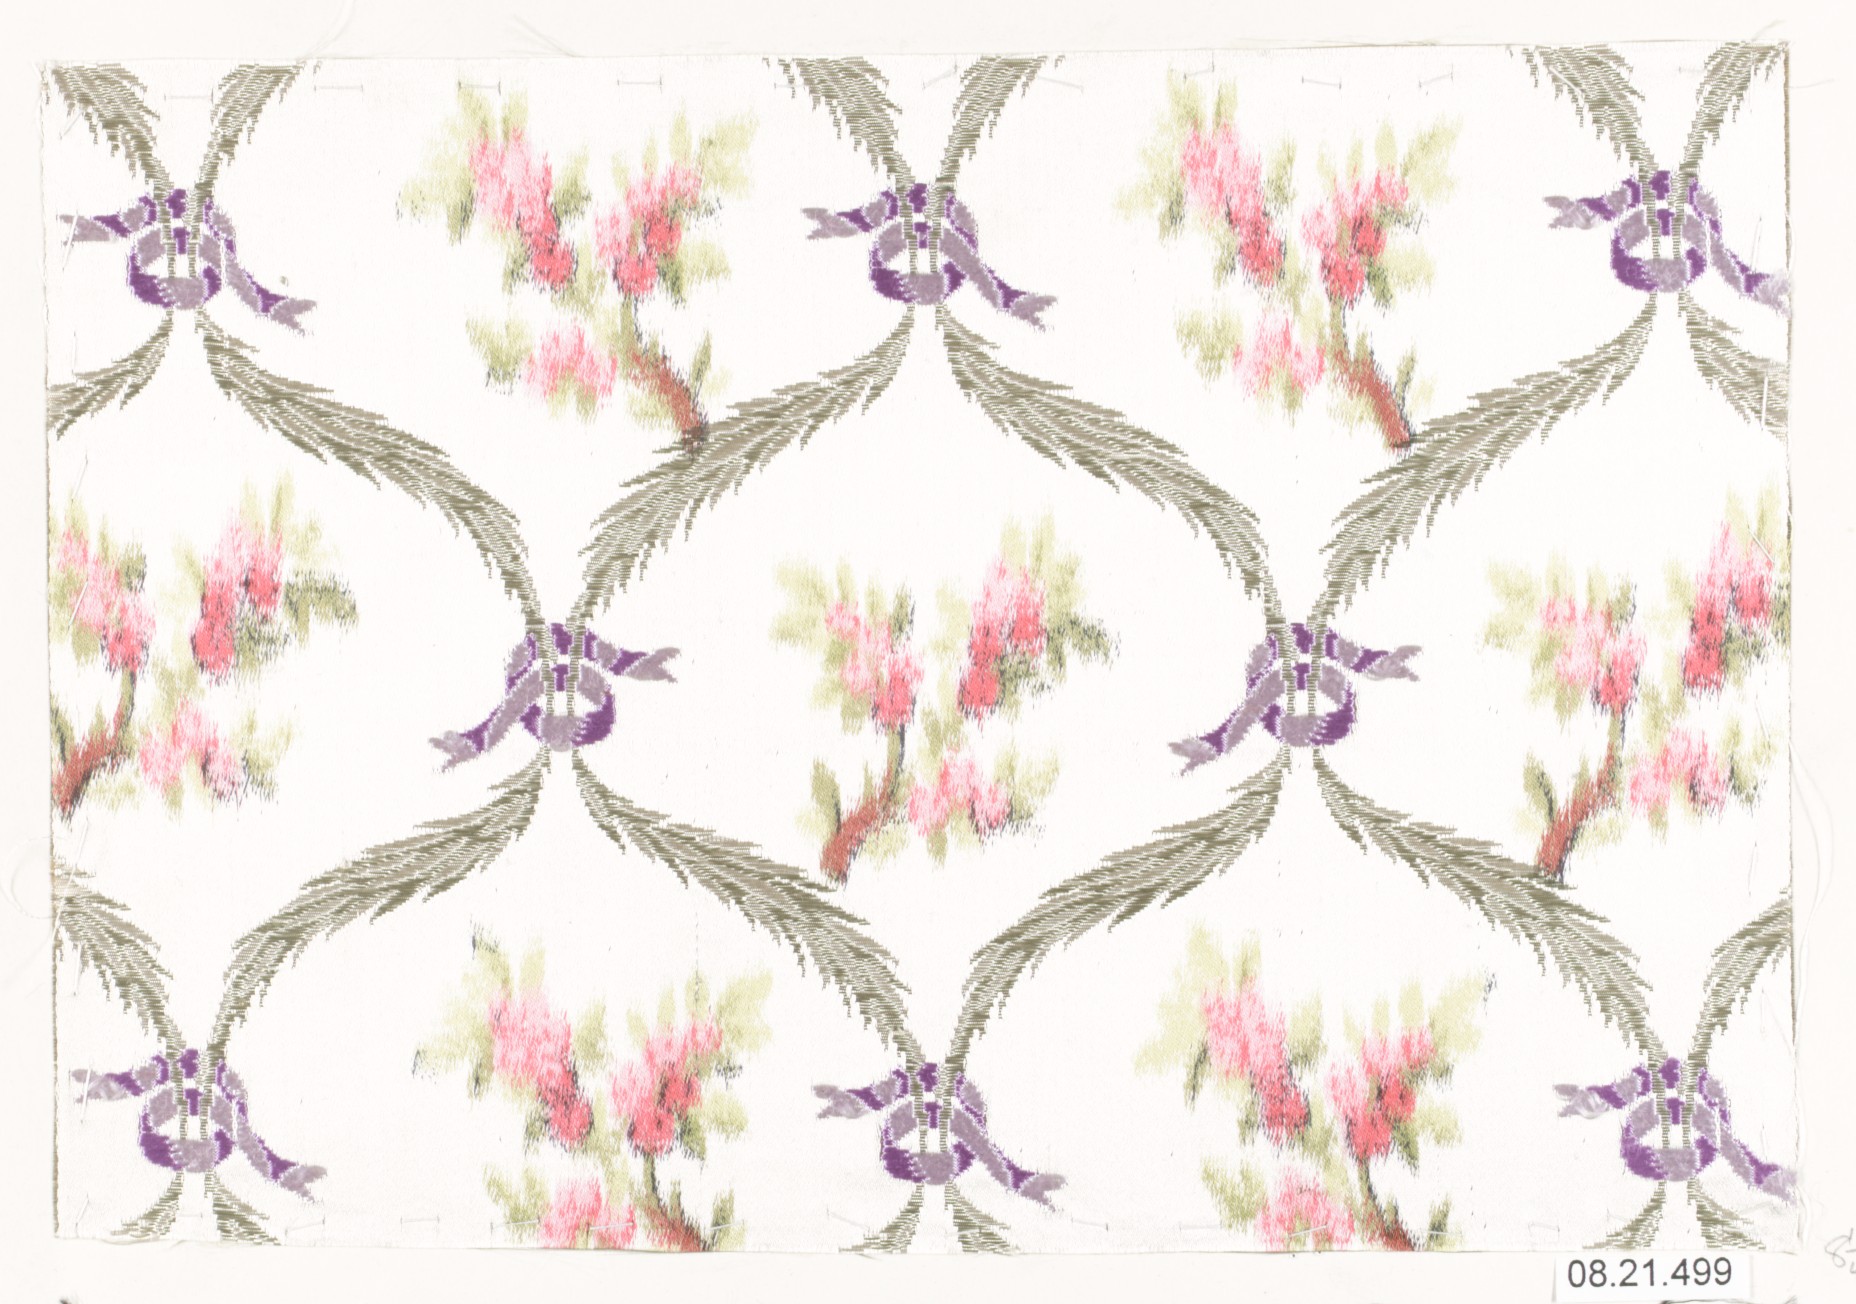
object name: textile sample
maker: Anonymous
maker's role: designer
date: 1900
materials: silk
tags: flowers